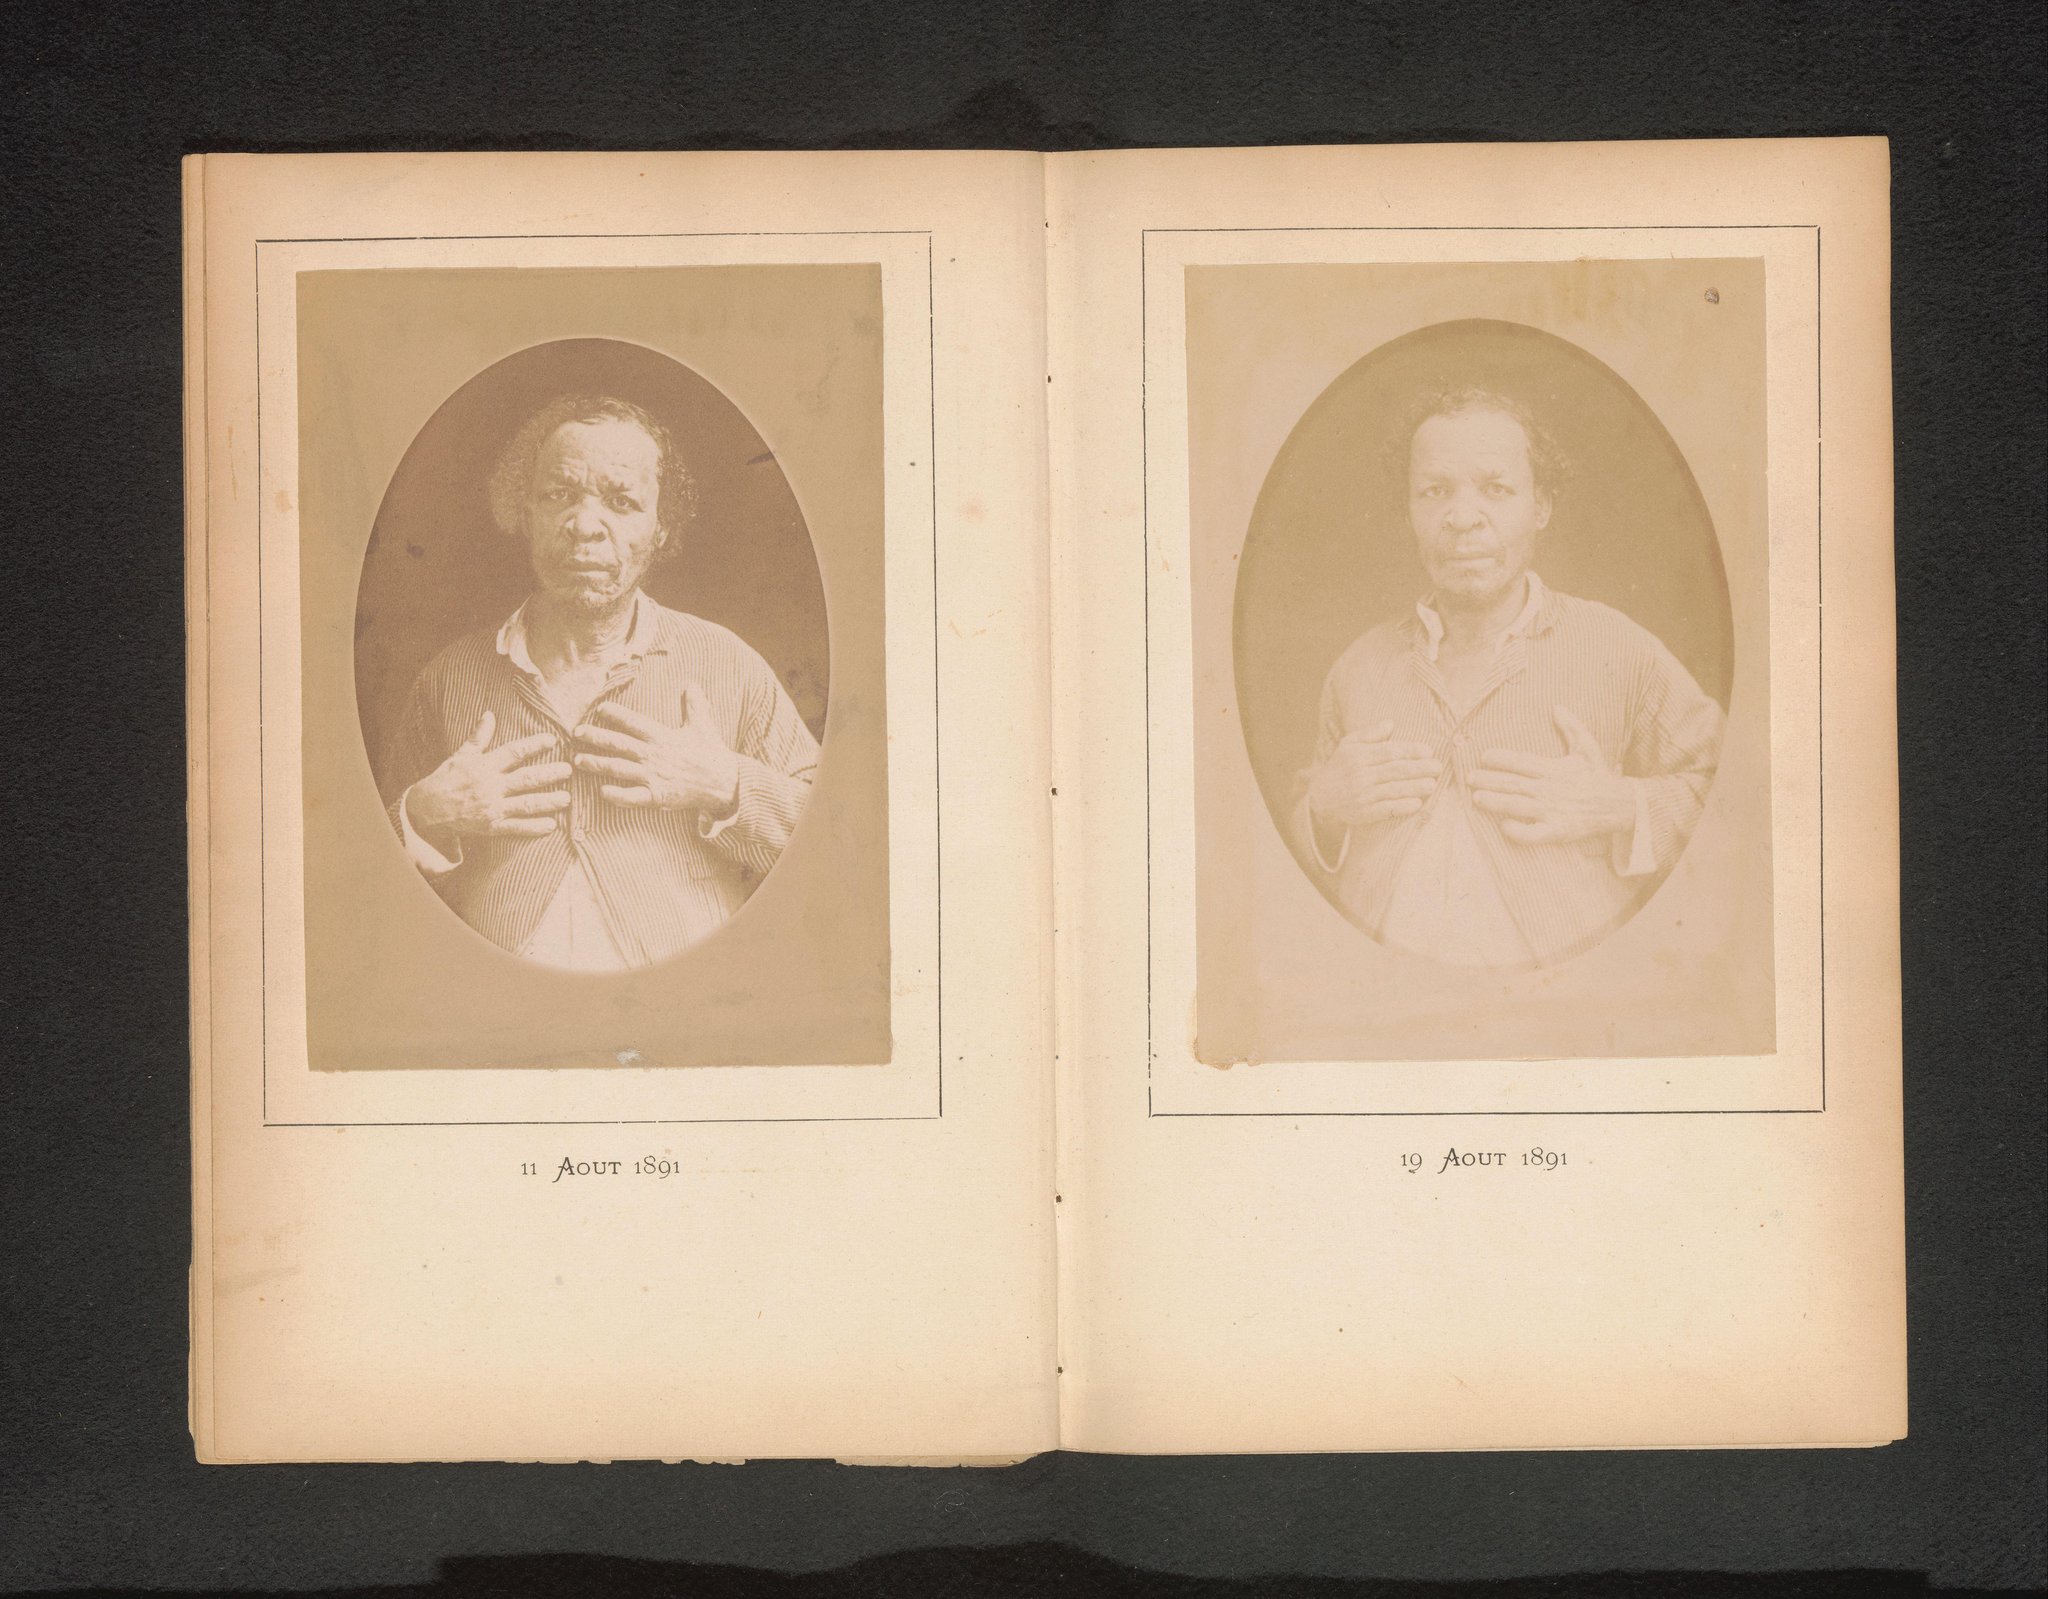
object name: photograph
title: Portret van een man met lepra, voor een behandeling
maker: Anonymous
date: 1891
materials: photographic support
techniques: albumen print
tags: leprosy, historical persons not known by name